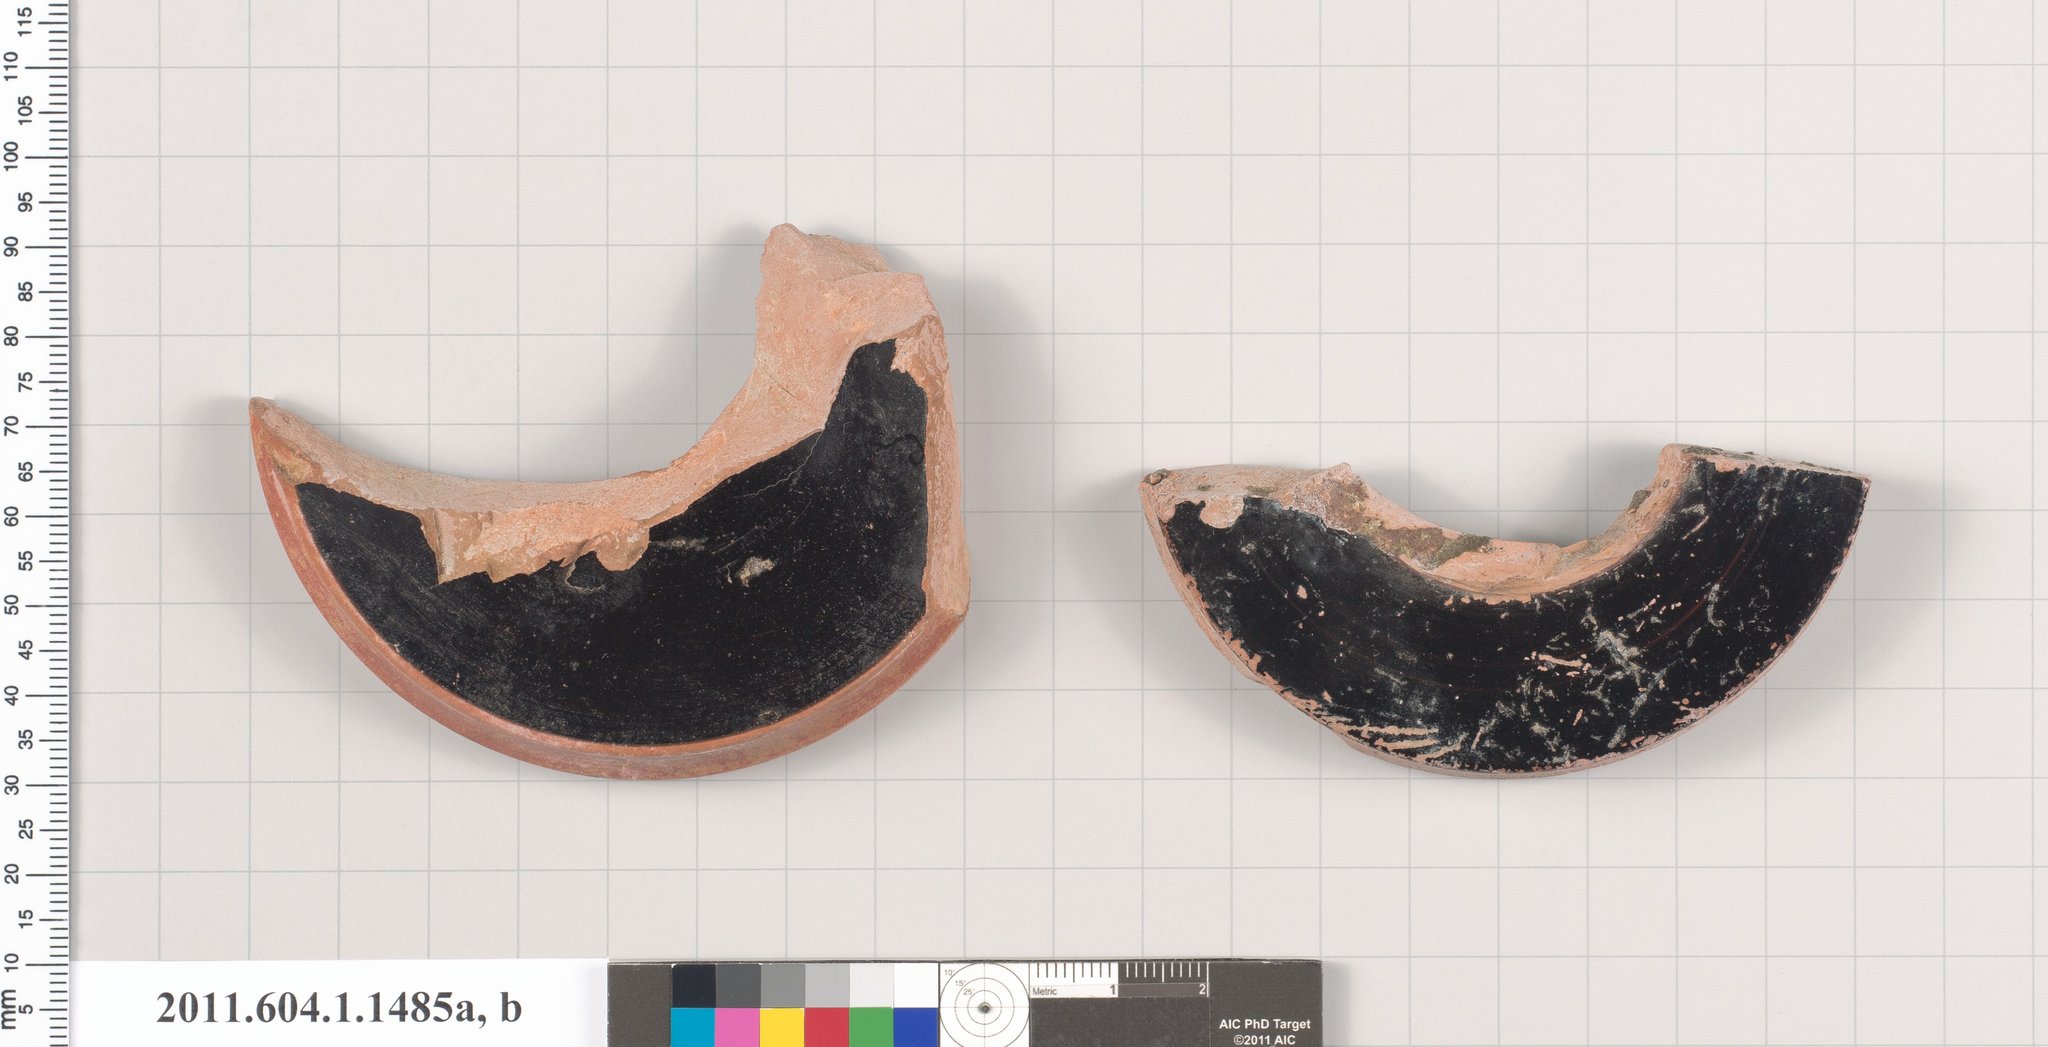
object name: kylix fragment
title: Terracotta fragments of kylikes (drinking cups)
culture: greek, attic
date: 500-401 BCE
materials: terracotta